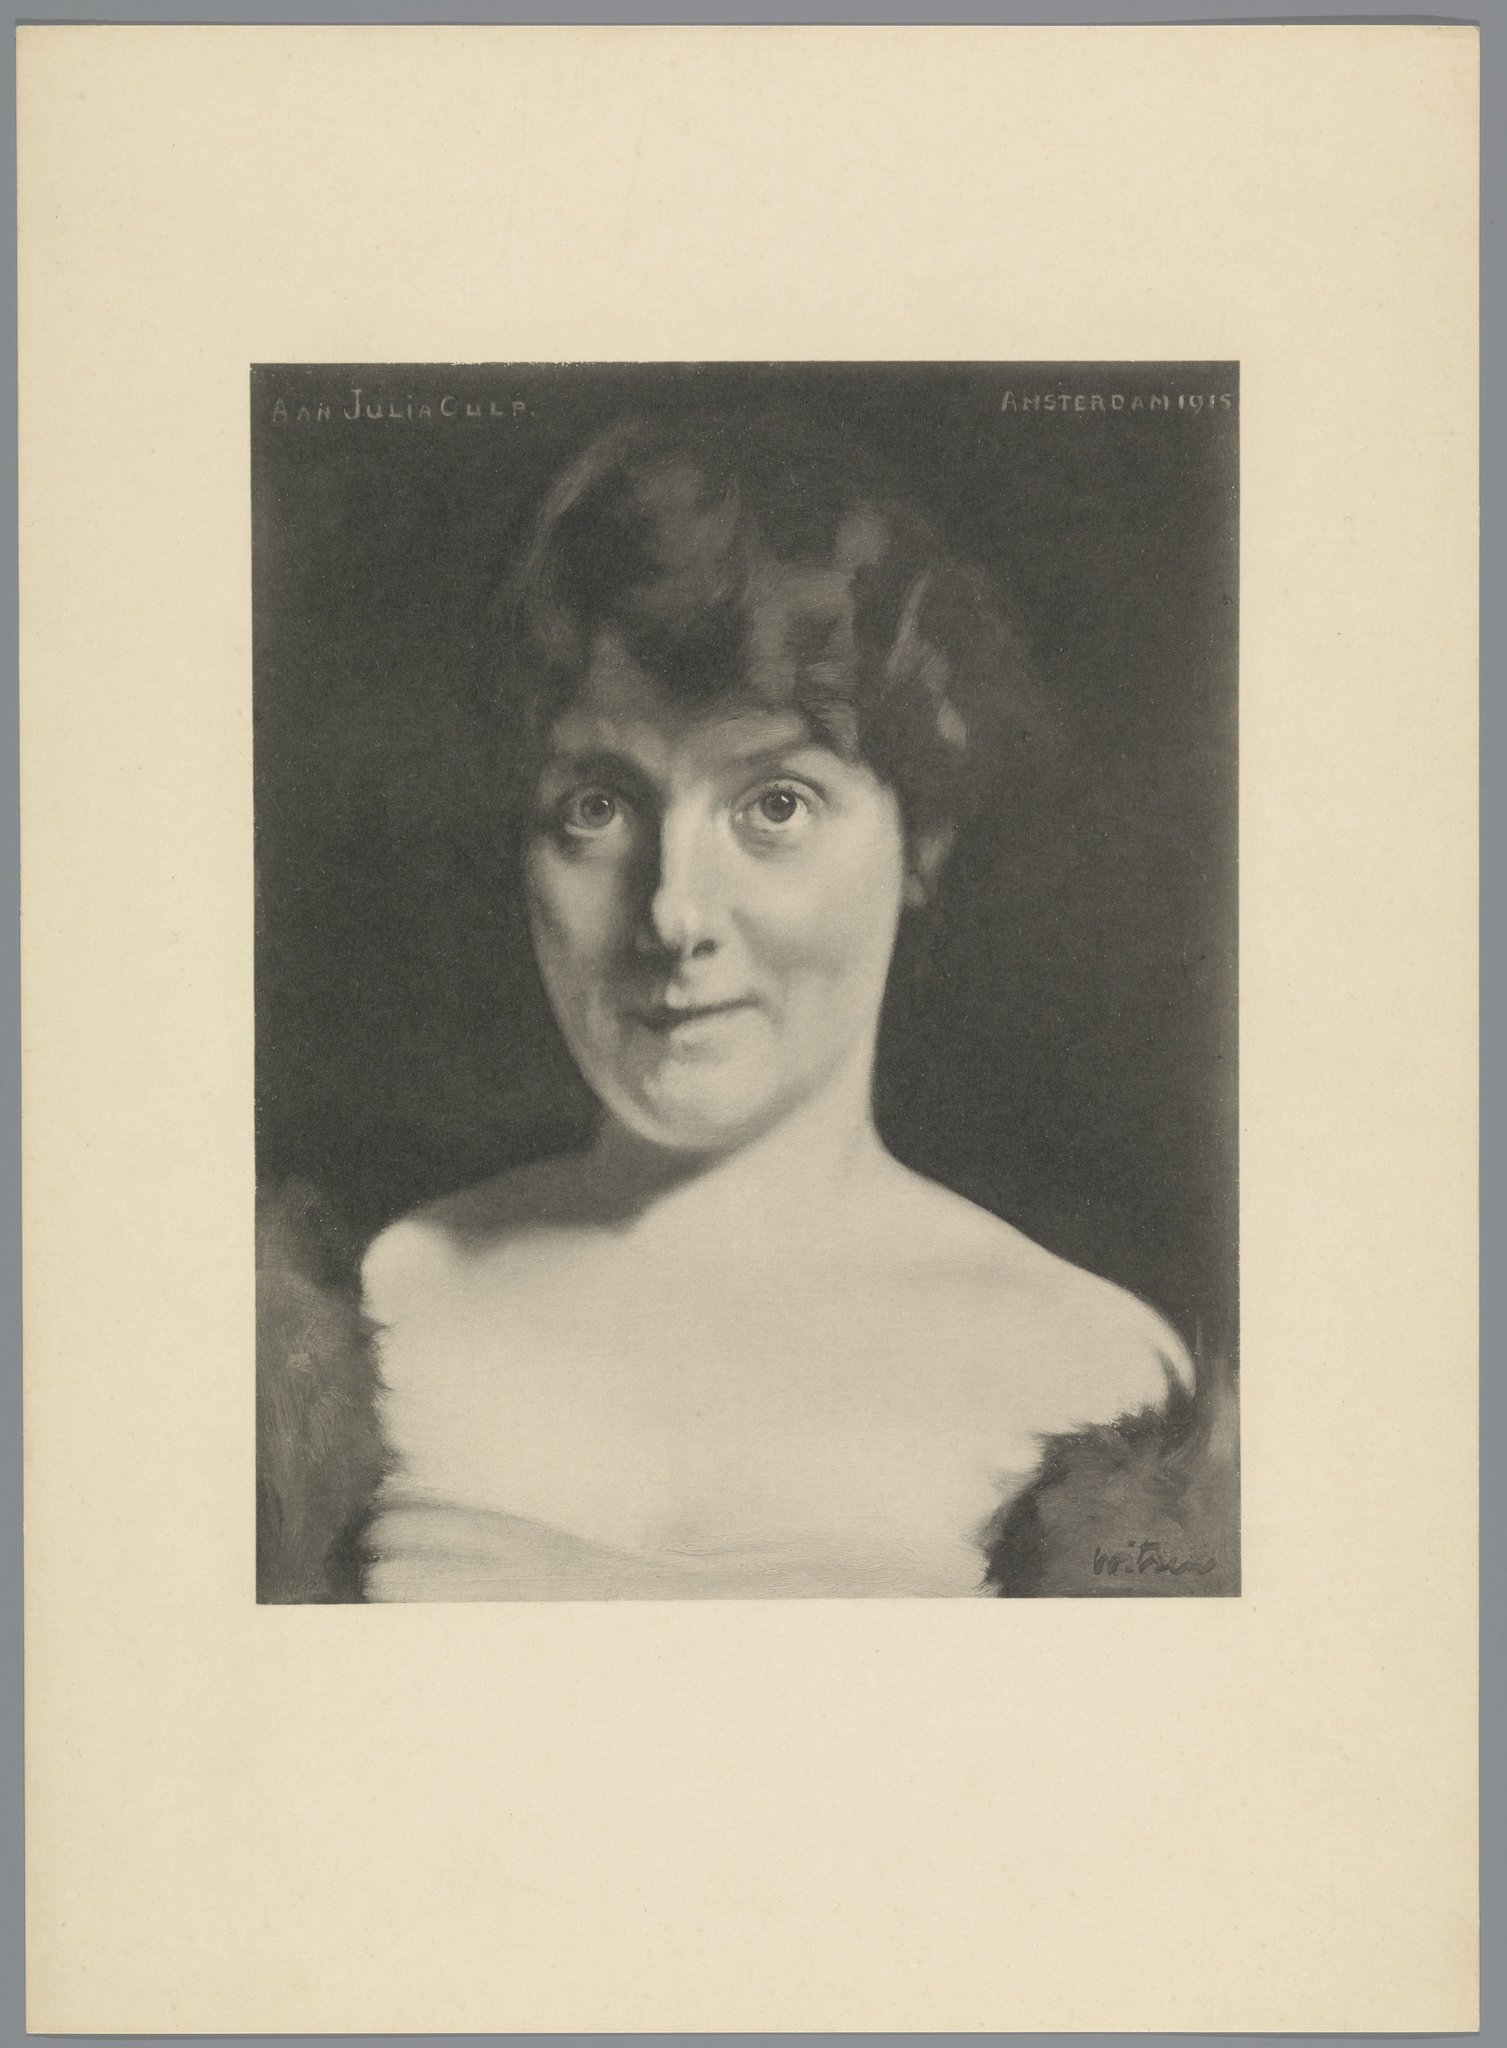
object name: print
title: Reproductie naar schilderij met portret van Julia Culp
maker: Anonymous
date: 1915-1925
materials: paper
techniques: photograph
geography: netherlands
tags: amsterdam